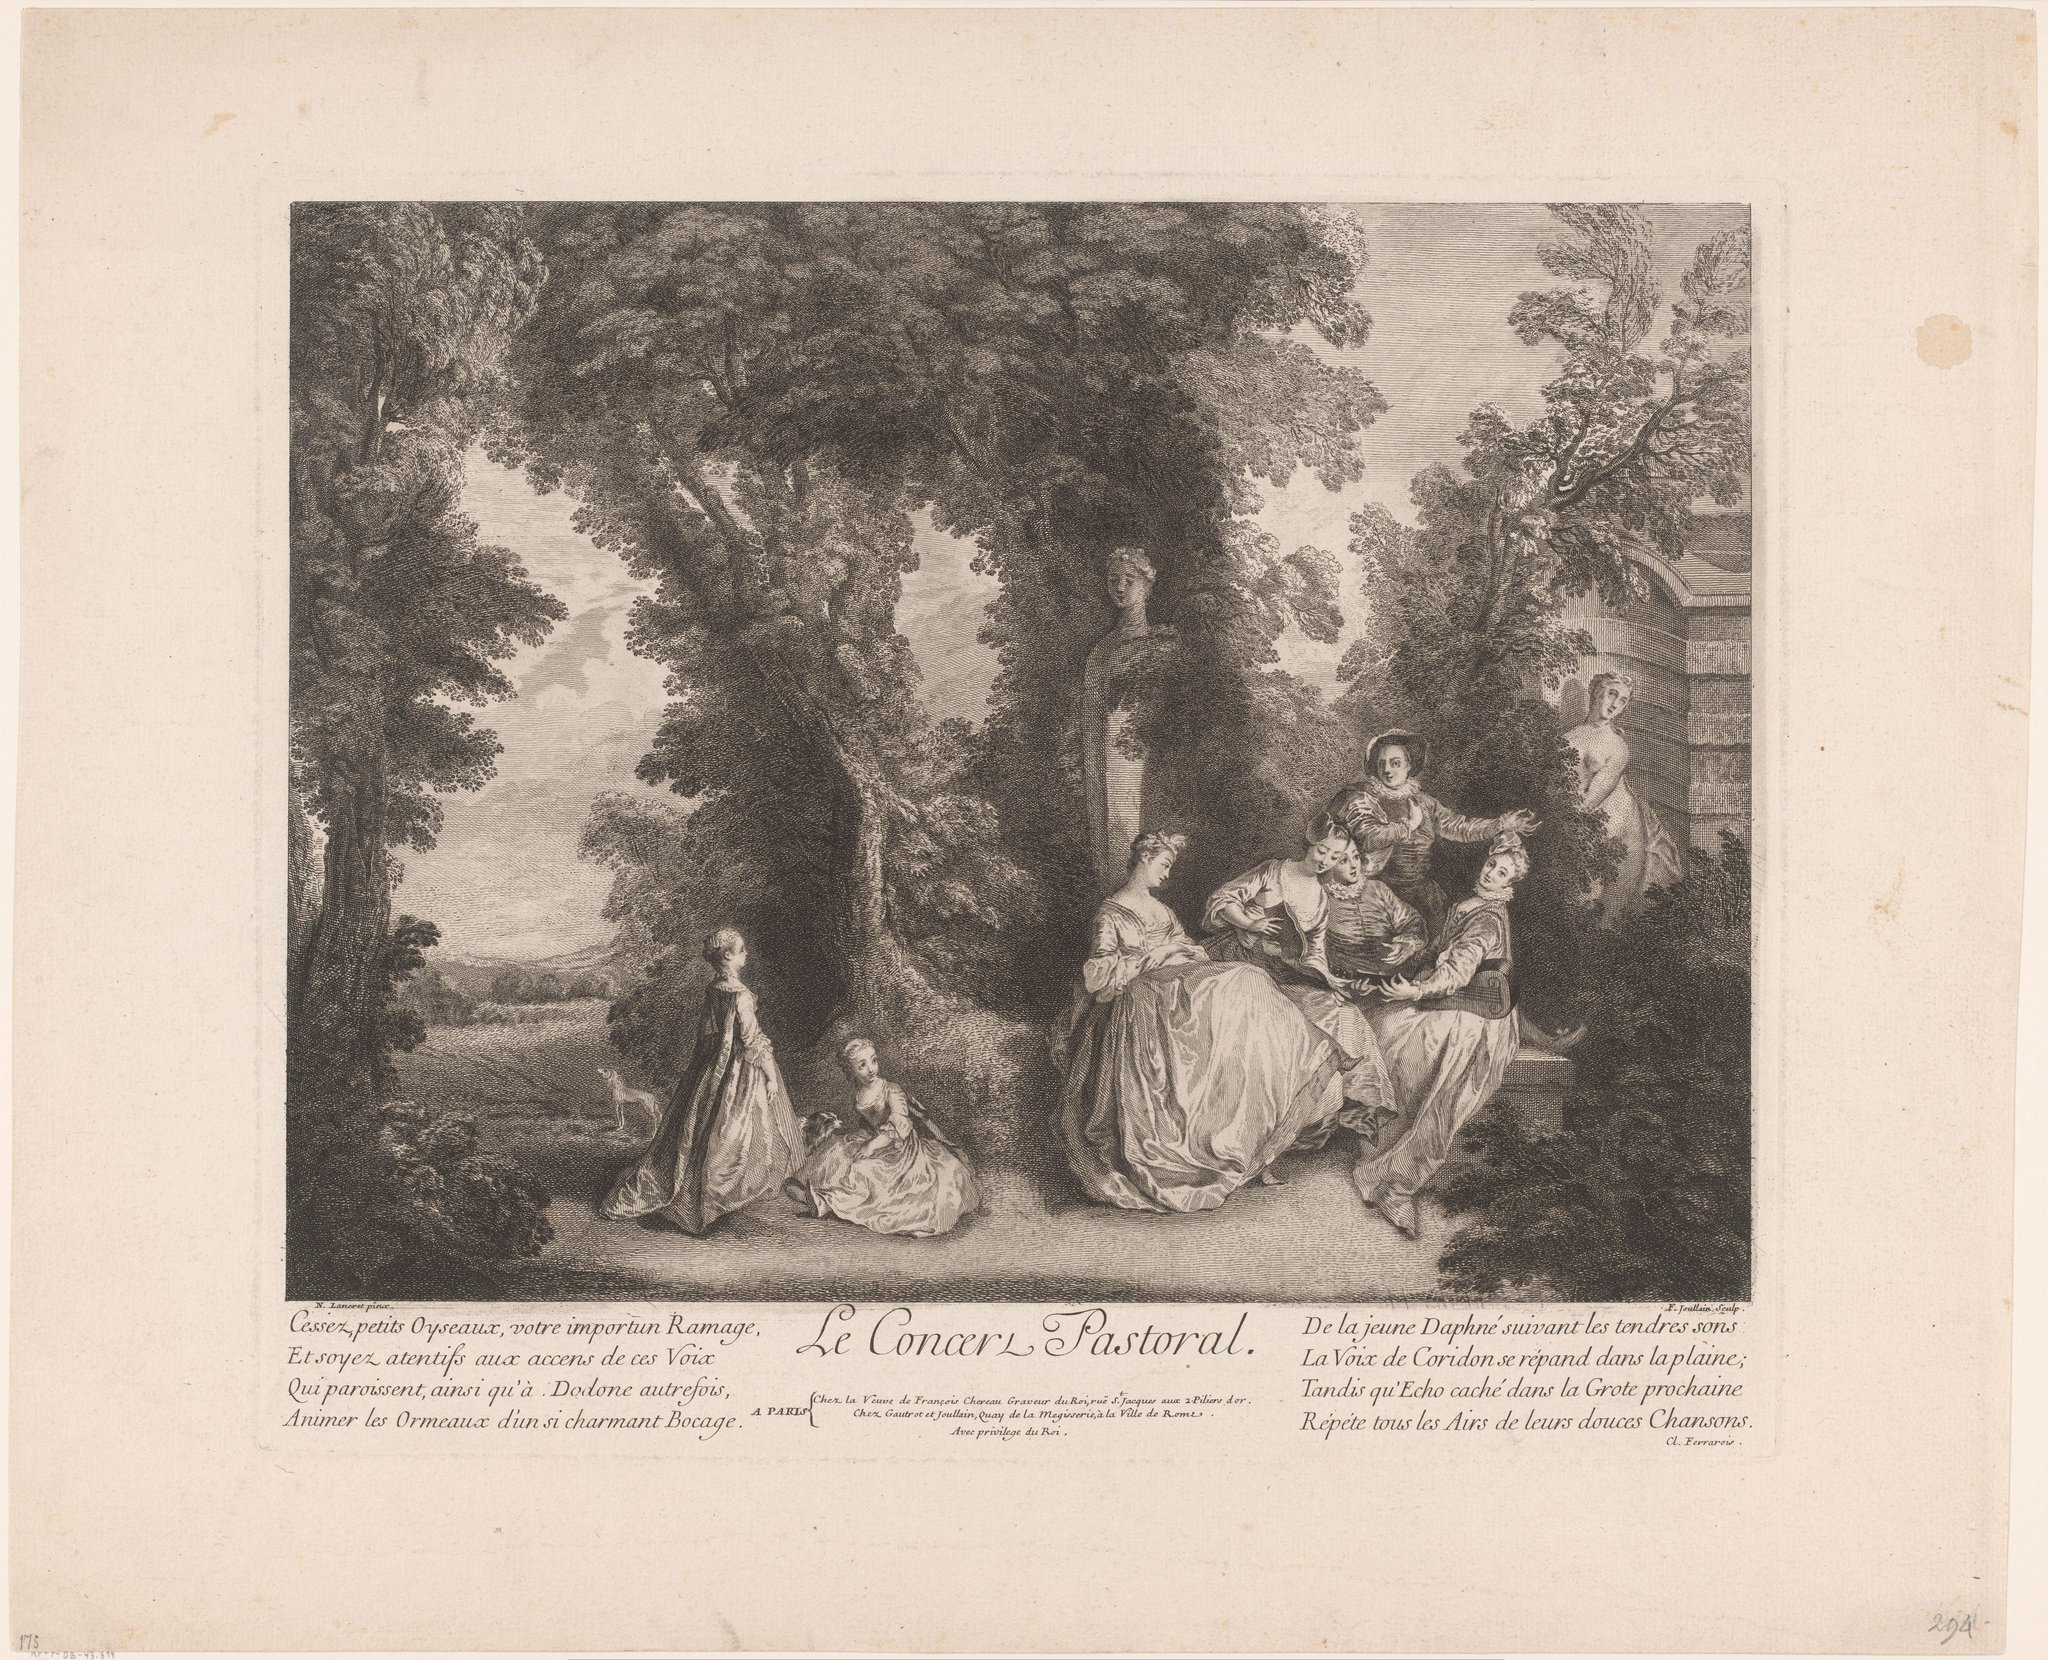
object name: print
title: Le Concert Pastoral.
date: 1734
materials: paper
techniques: engraving, etching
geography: france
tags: clothes, costume (+ women's clothes), garden of love, court of love, 'fête galante', clothes, costume (+ men's clothes)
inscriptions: watermark, collector's mark: Lugt 240